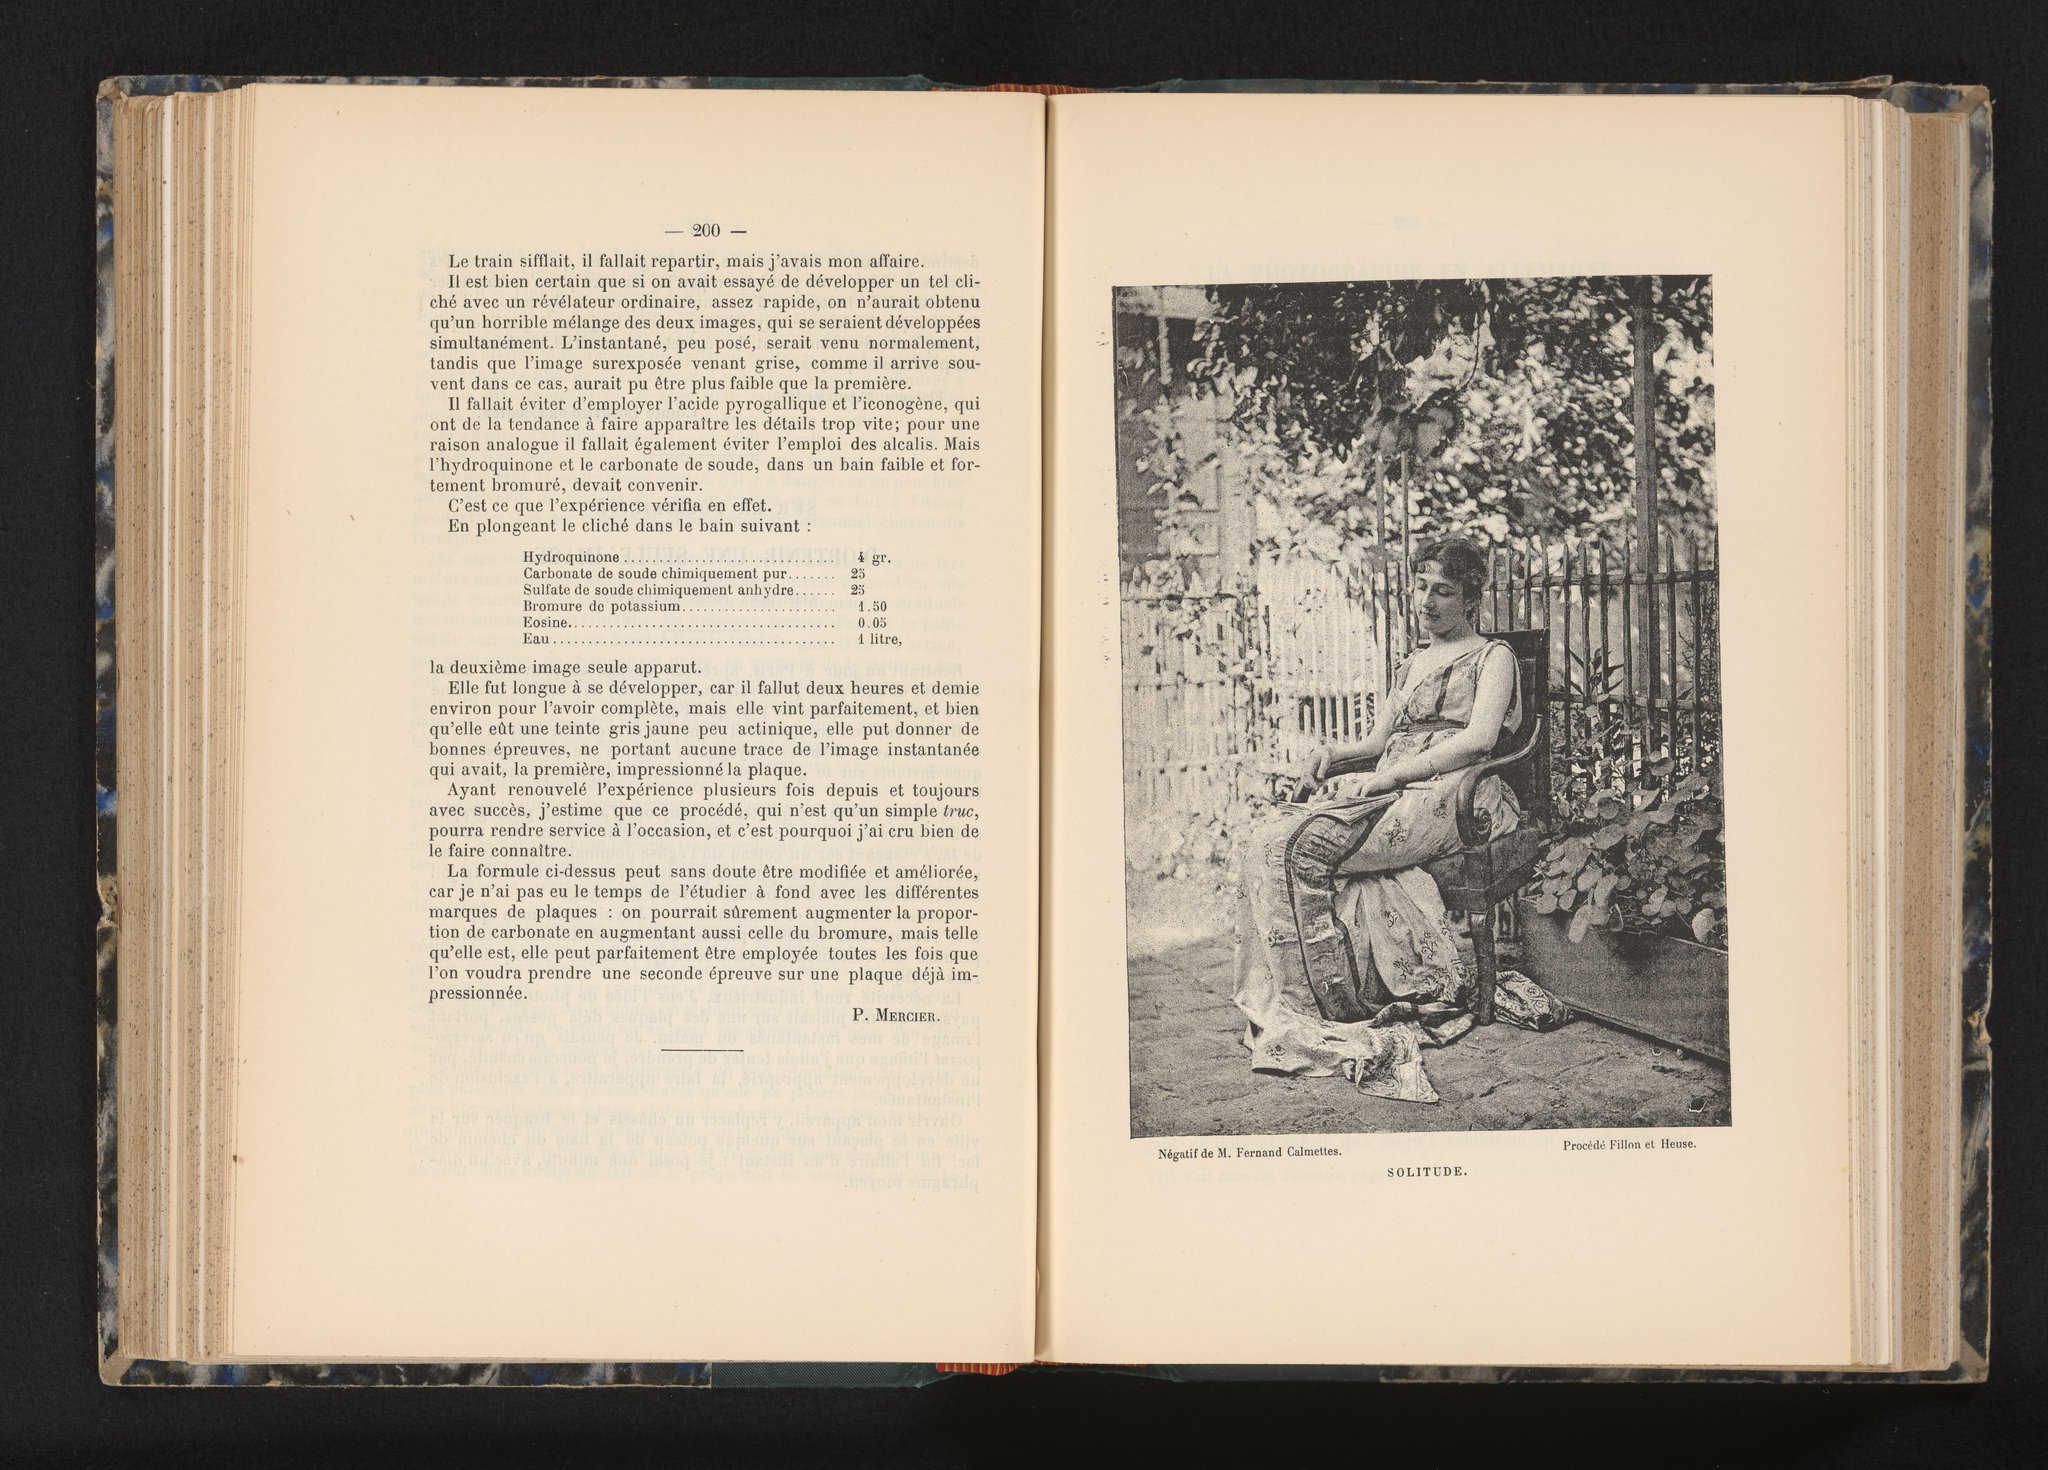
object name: photomechanical print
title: Portret van een onbekende vrouw op een stoel in een tuin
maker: fernand calmettes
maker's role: painter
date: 1891-1896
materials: paper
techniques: collo-autotype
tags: historical persons - bb - woman, garden